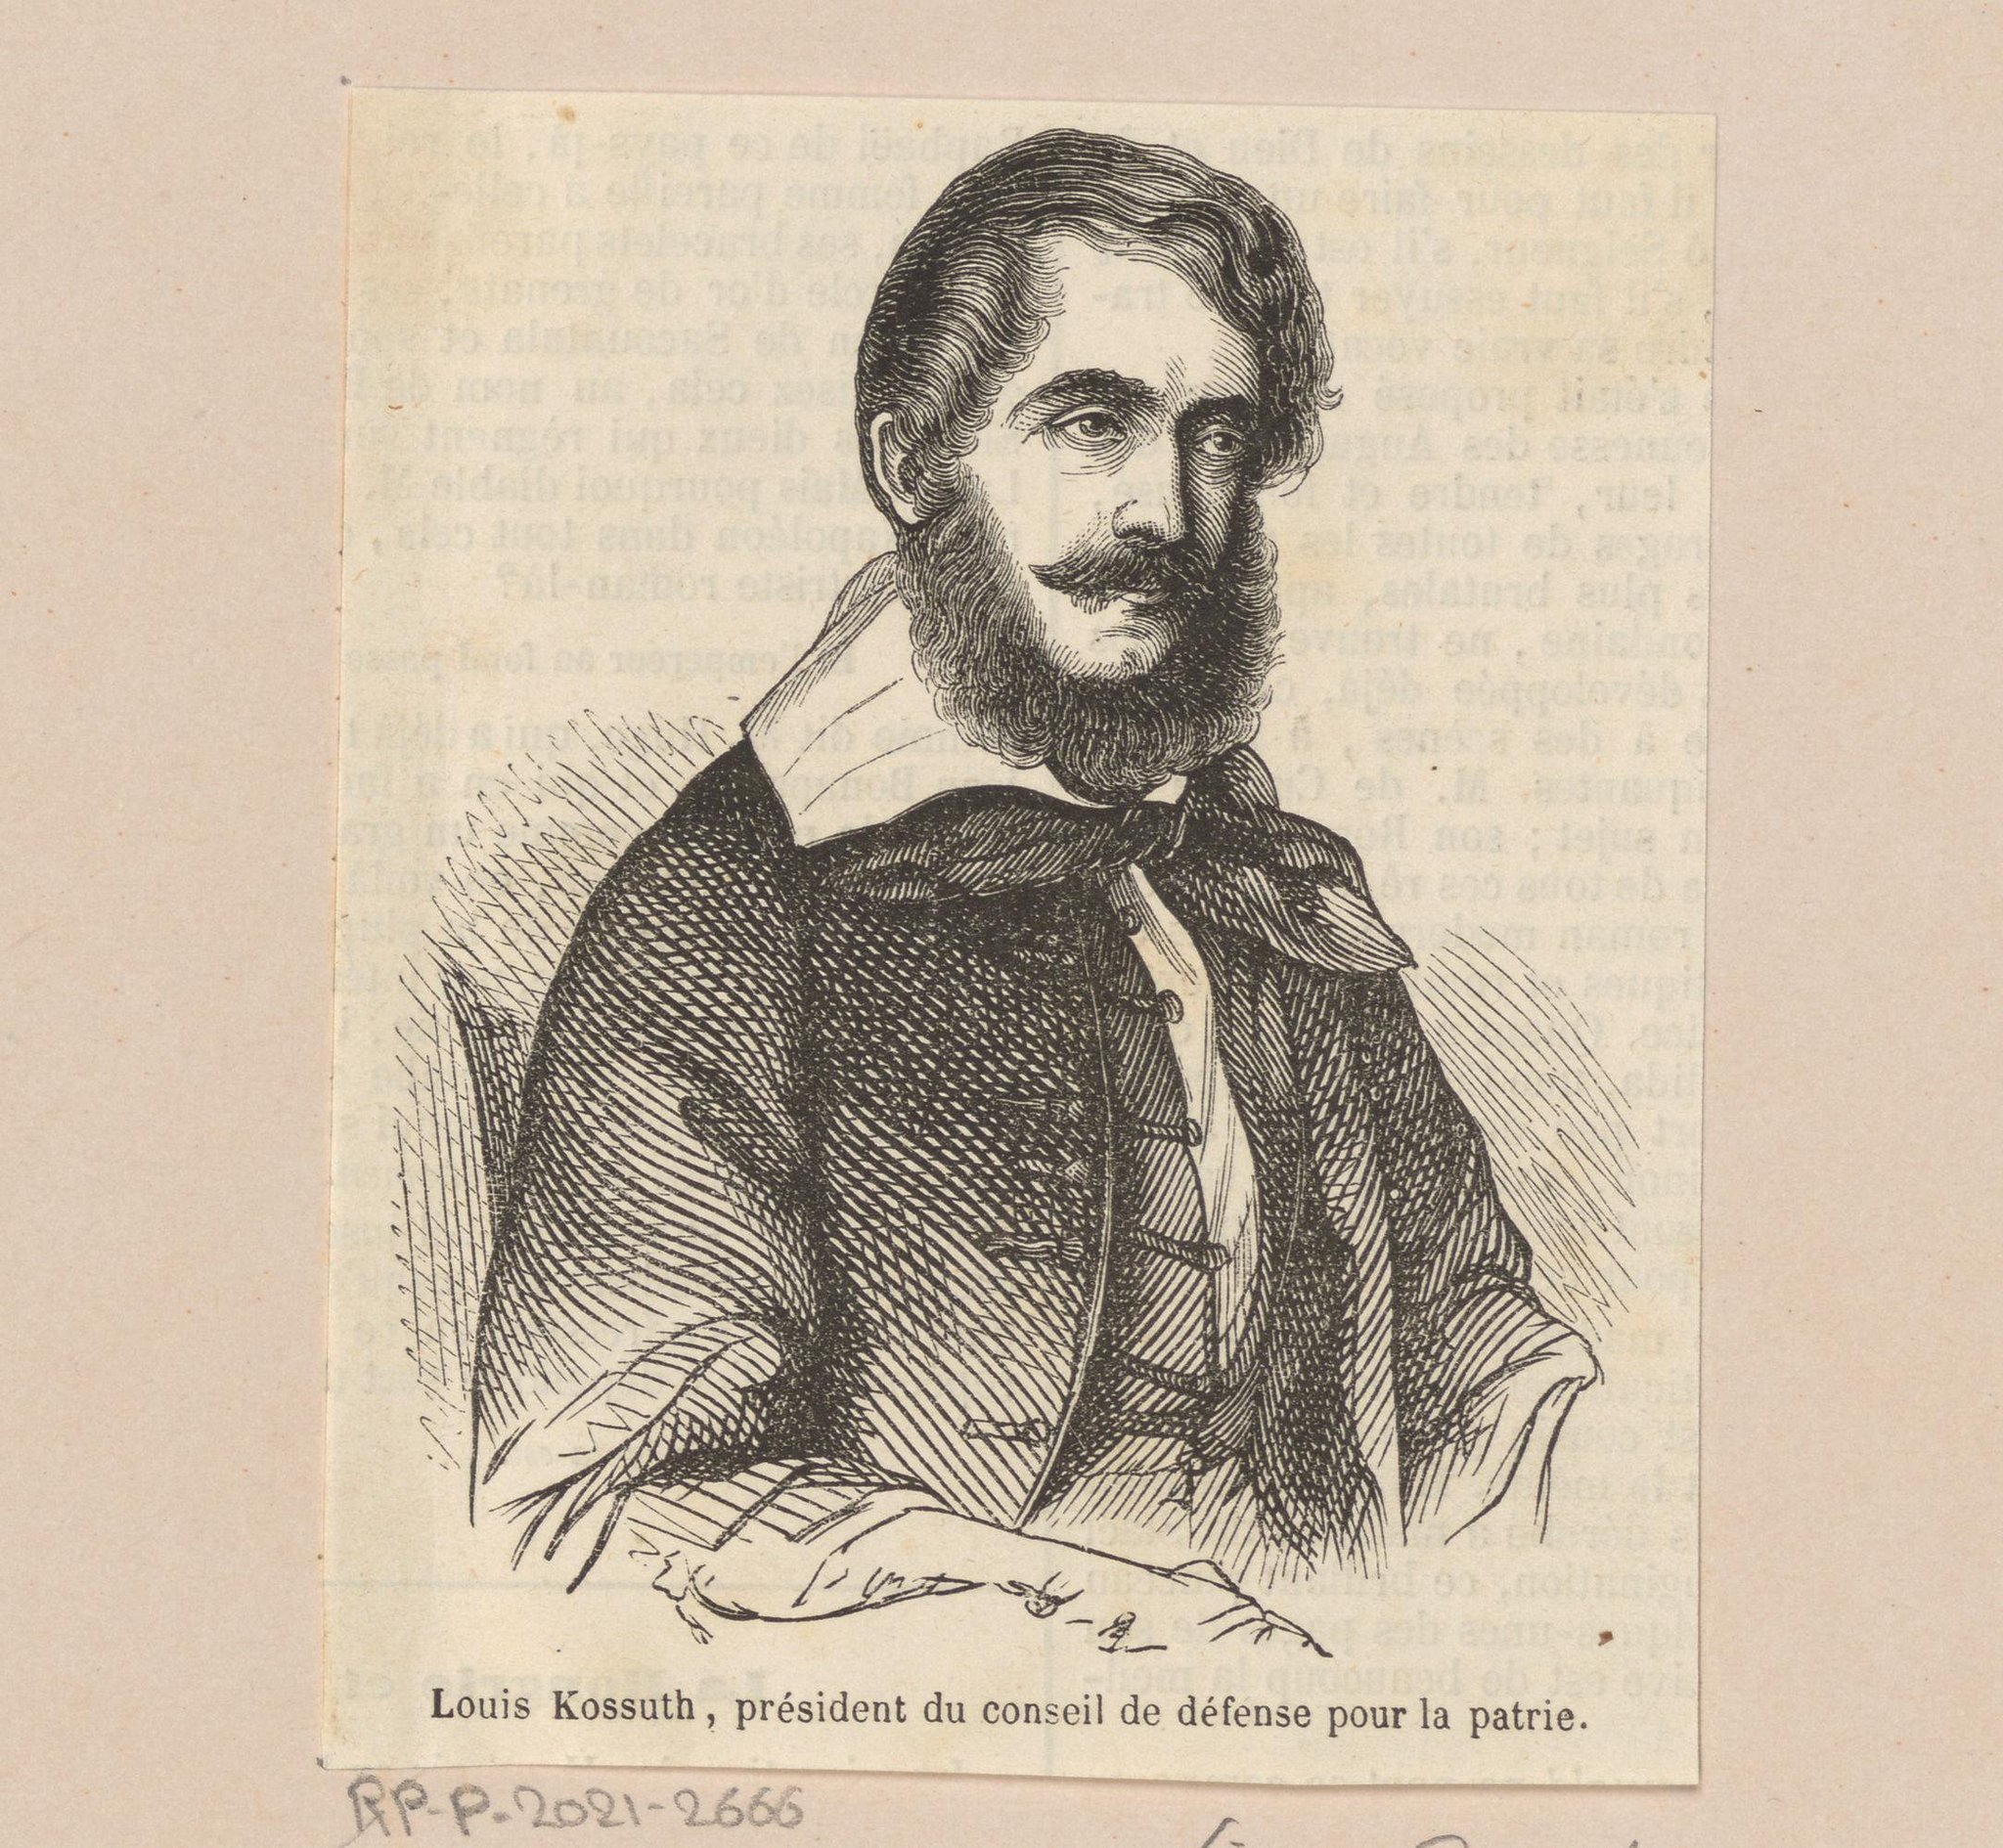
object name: print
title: Portret van Lajos Kossuth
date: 1848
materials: paper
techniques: letterpress printing, engraving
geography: versailles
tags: historical persons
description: Prent uit: L'Illustration, nr. 296, vol. XII, 28 oktober 1848.